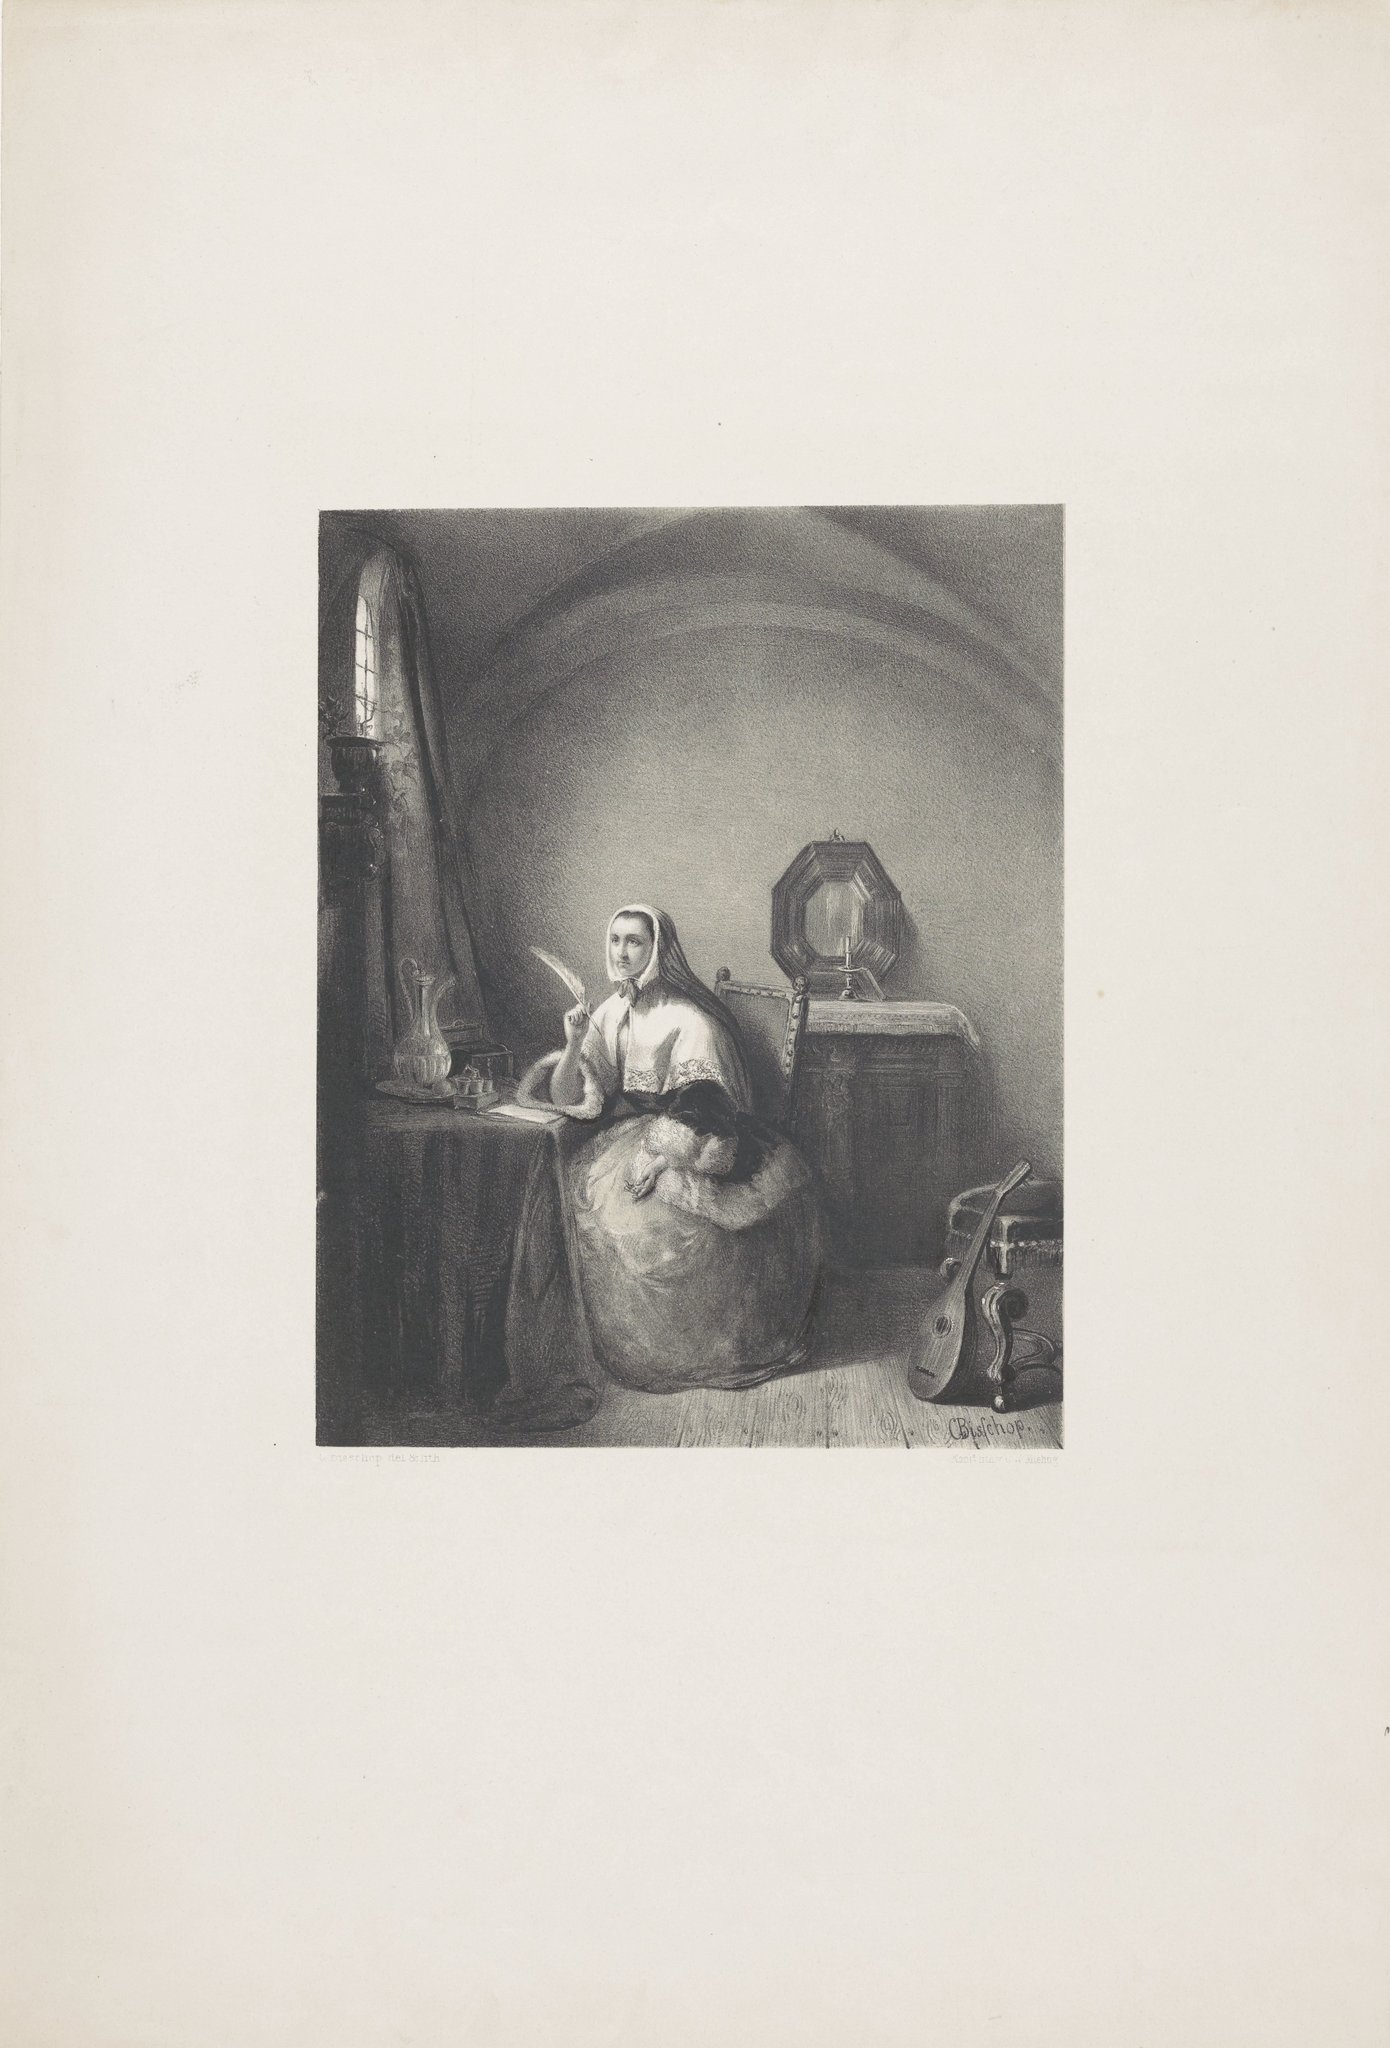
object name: print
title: Schrijvende vrouw bij het raam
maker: christoffel bisschop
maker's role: draughtsman, print maker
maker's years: 1828-1904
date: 1838-1904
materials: paper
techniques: lithograph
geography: netherlands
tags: candlestick (+ extinguishing; extinguished light, lamp, candle), mirror, writing and letters, lute, and special forms of lute, e.g.: theorbo, plants and herbs: ivy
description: De vrouw heeft een ganzenveer in haar hand. Op de tafel voor haar staan een karaf, een kistje en schrijfgerei. In de gewelfde ruimte achter haar staan een kastje, een spiegel met een gedoofde kaars ervoor, een stoel en een luit. Bij het raam staat een pot met klimop. De vrouw draagt een muts met sleep en een met bont afgezette mantel.